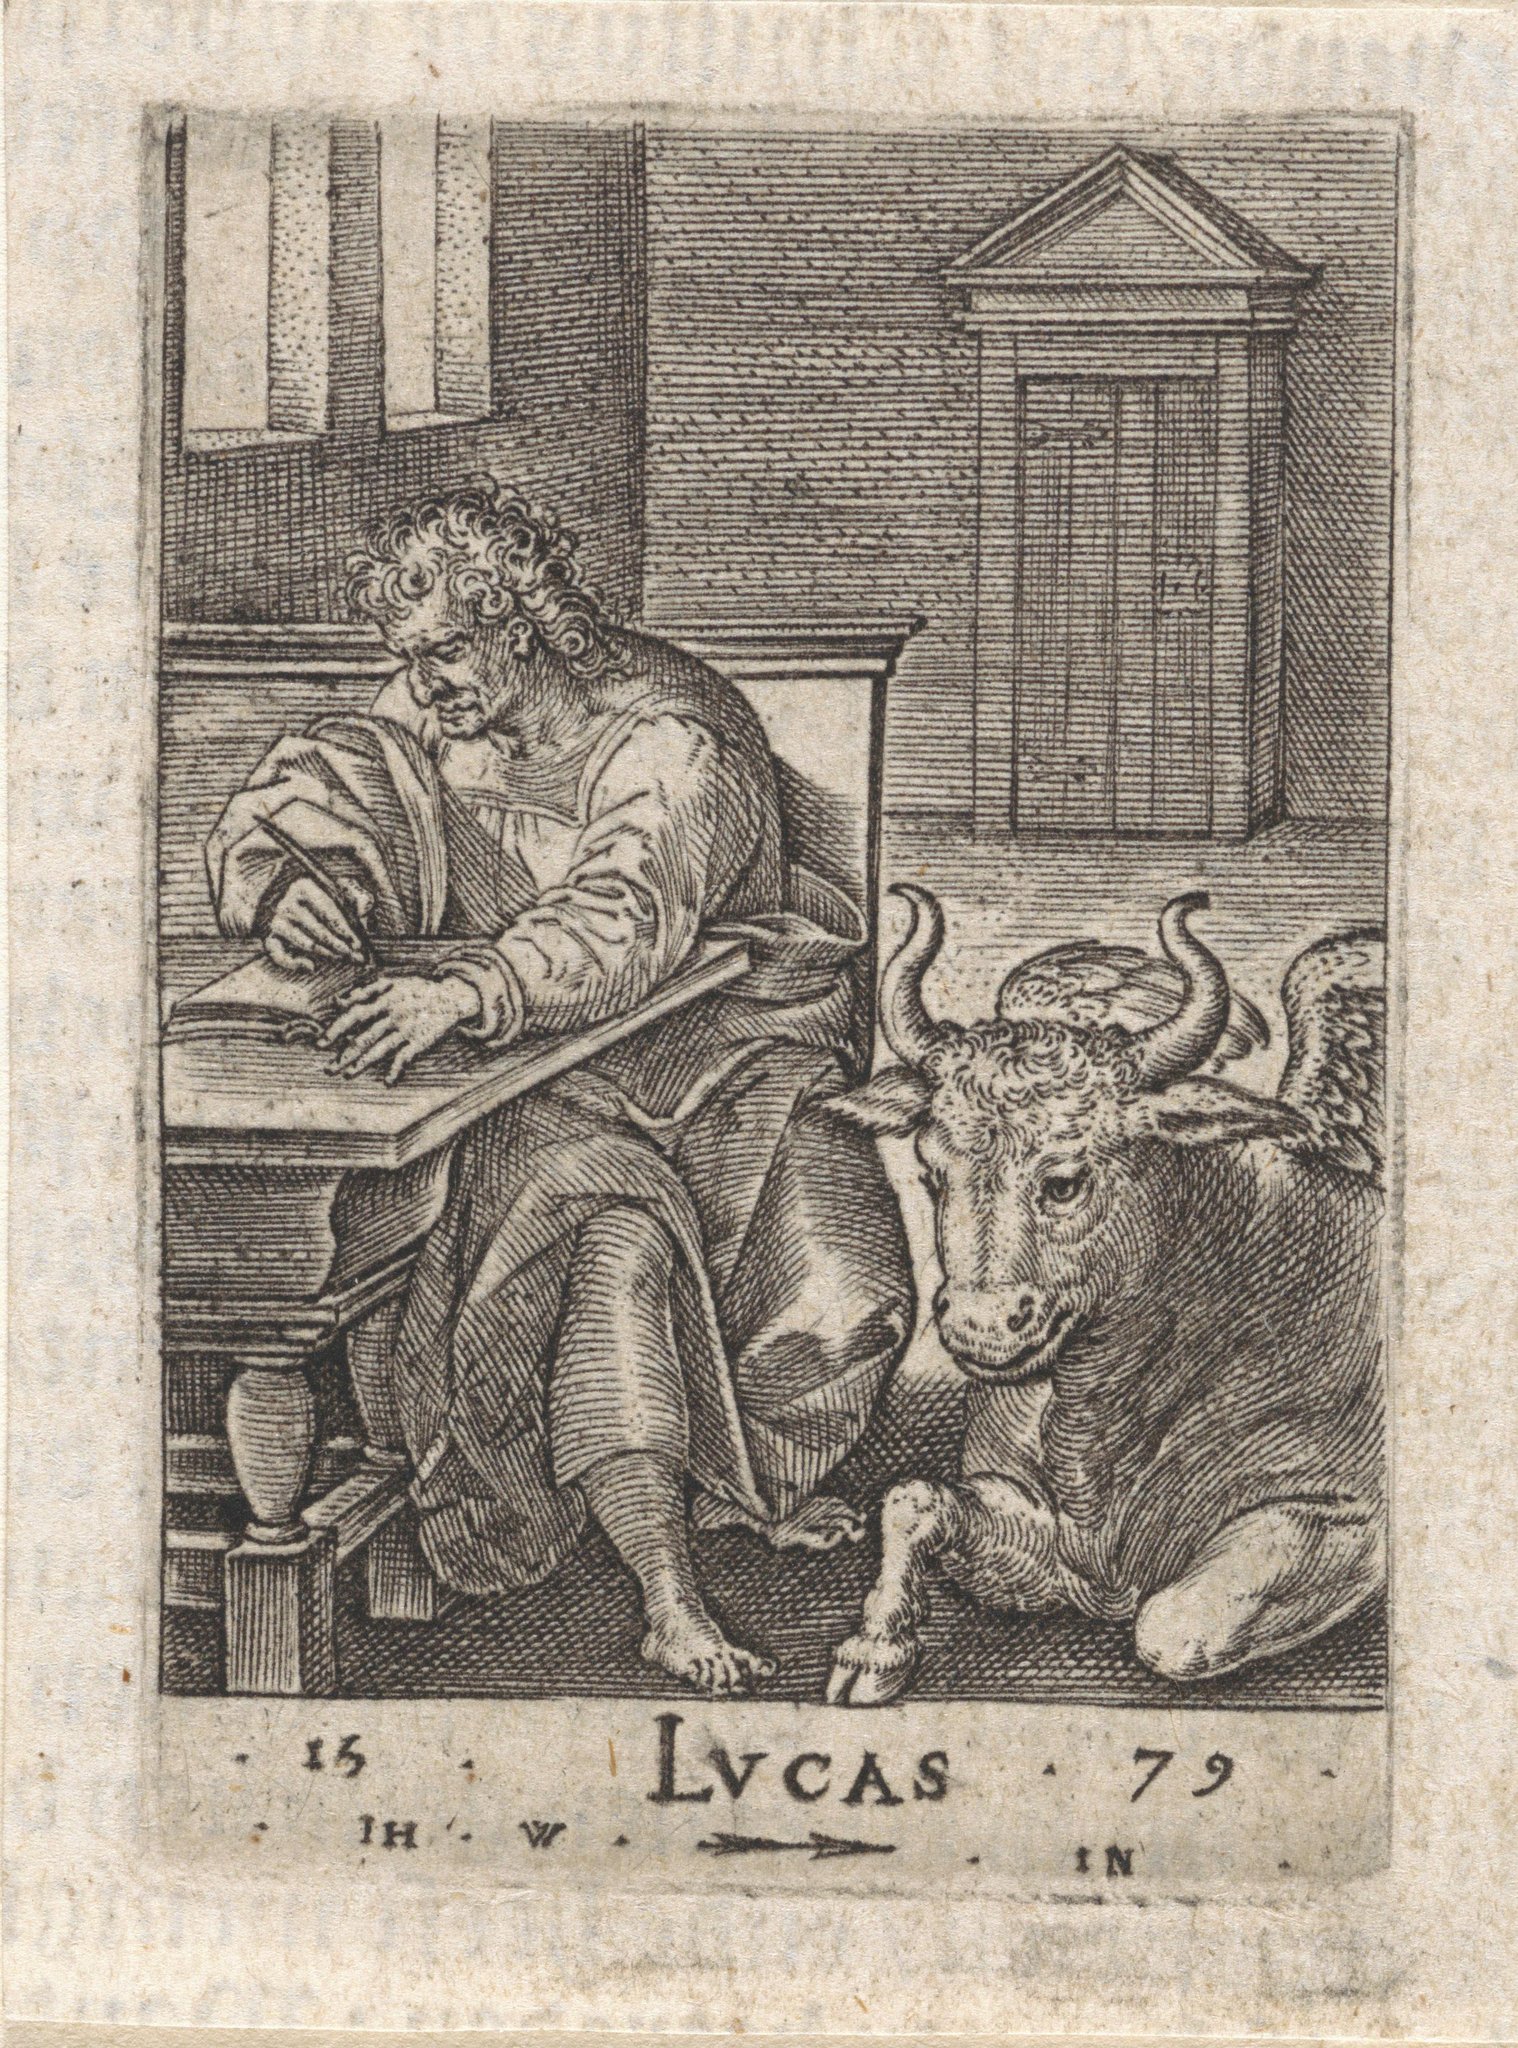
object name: book illustration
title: Vier evangelisten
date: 1579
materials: paper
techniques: engraving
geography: antwerp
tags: st. luke writing his gospel, usually a (winged) ox present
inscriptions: collector's mark: Lugt 2228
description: Prent gebruikt als illustratie in: Const-toonneel, inhoudende de beschrijvinghe ende XL. Heerlijcke afbeeldindinghen: Onses Heeren Jesu Christi, met sijne apostelen, ende evangelisten, midtsgaders de hooft-deuchden ende ondeuchden. Ende ten laetsten de seven planeten. In coper gesneden door Johannis Wierix. De beschrijvinge is (...). Delft: Nicolaes de Clerck, 1609.